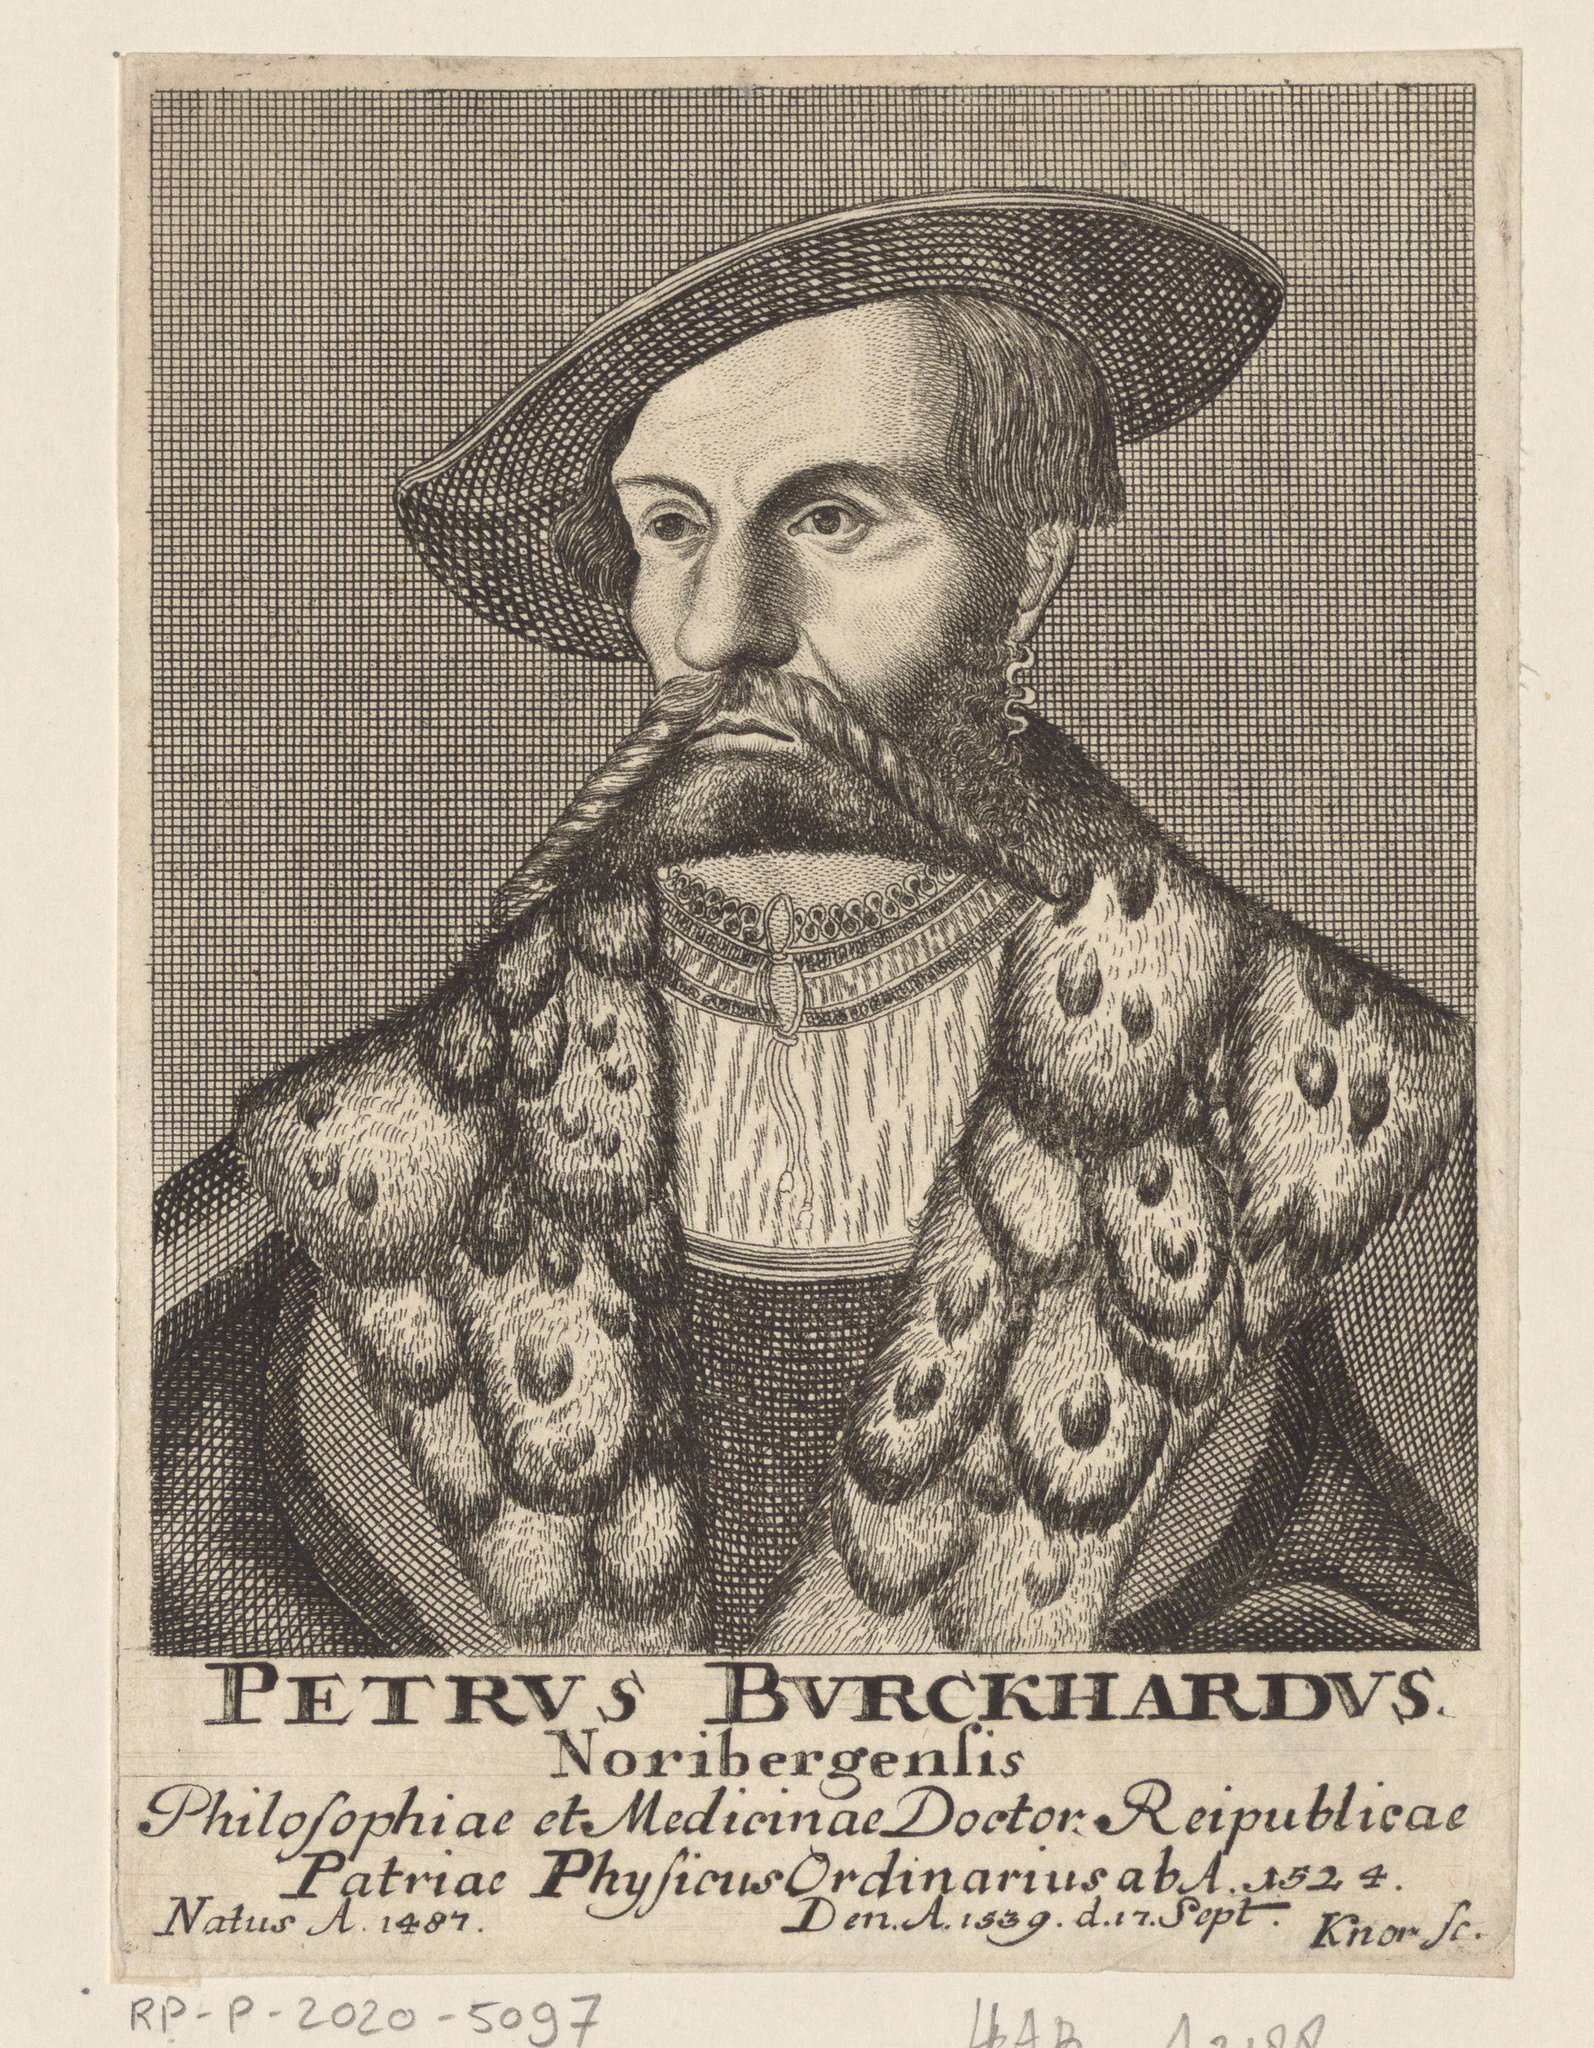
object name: print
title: Portret van Peter Burckhard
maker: georg wolfgang knorr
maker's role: print maker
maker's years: 1705-1761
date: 1715-1761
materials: paper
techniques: engraving, etching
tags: historical persons, physician, doctor